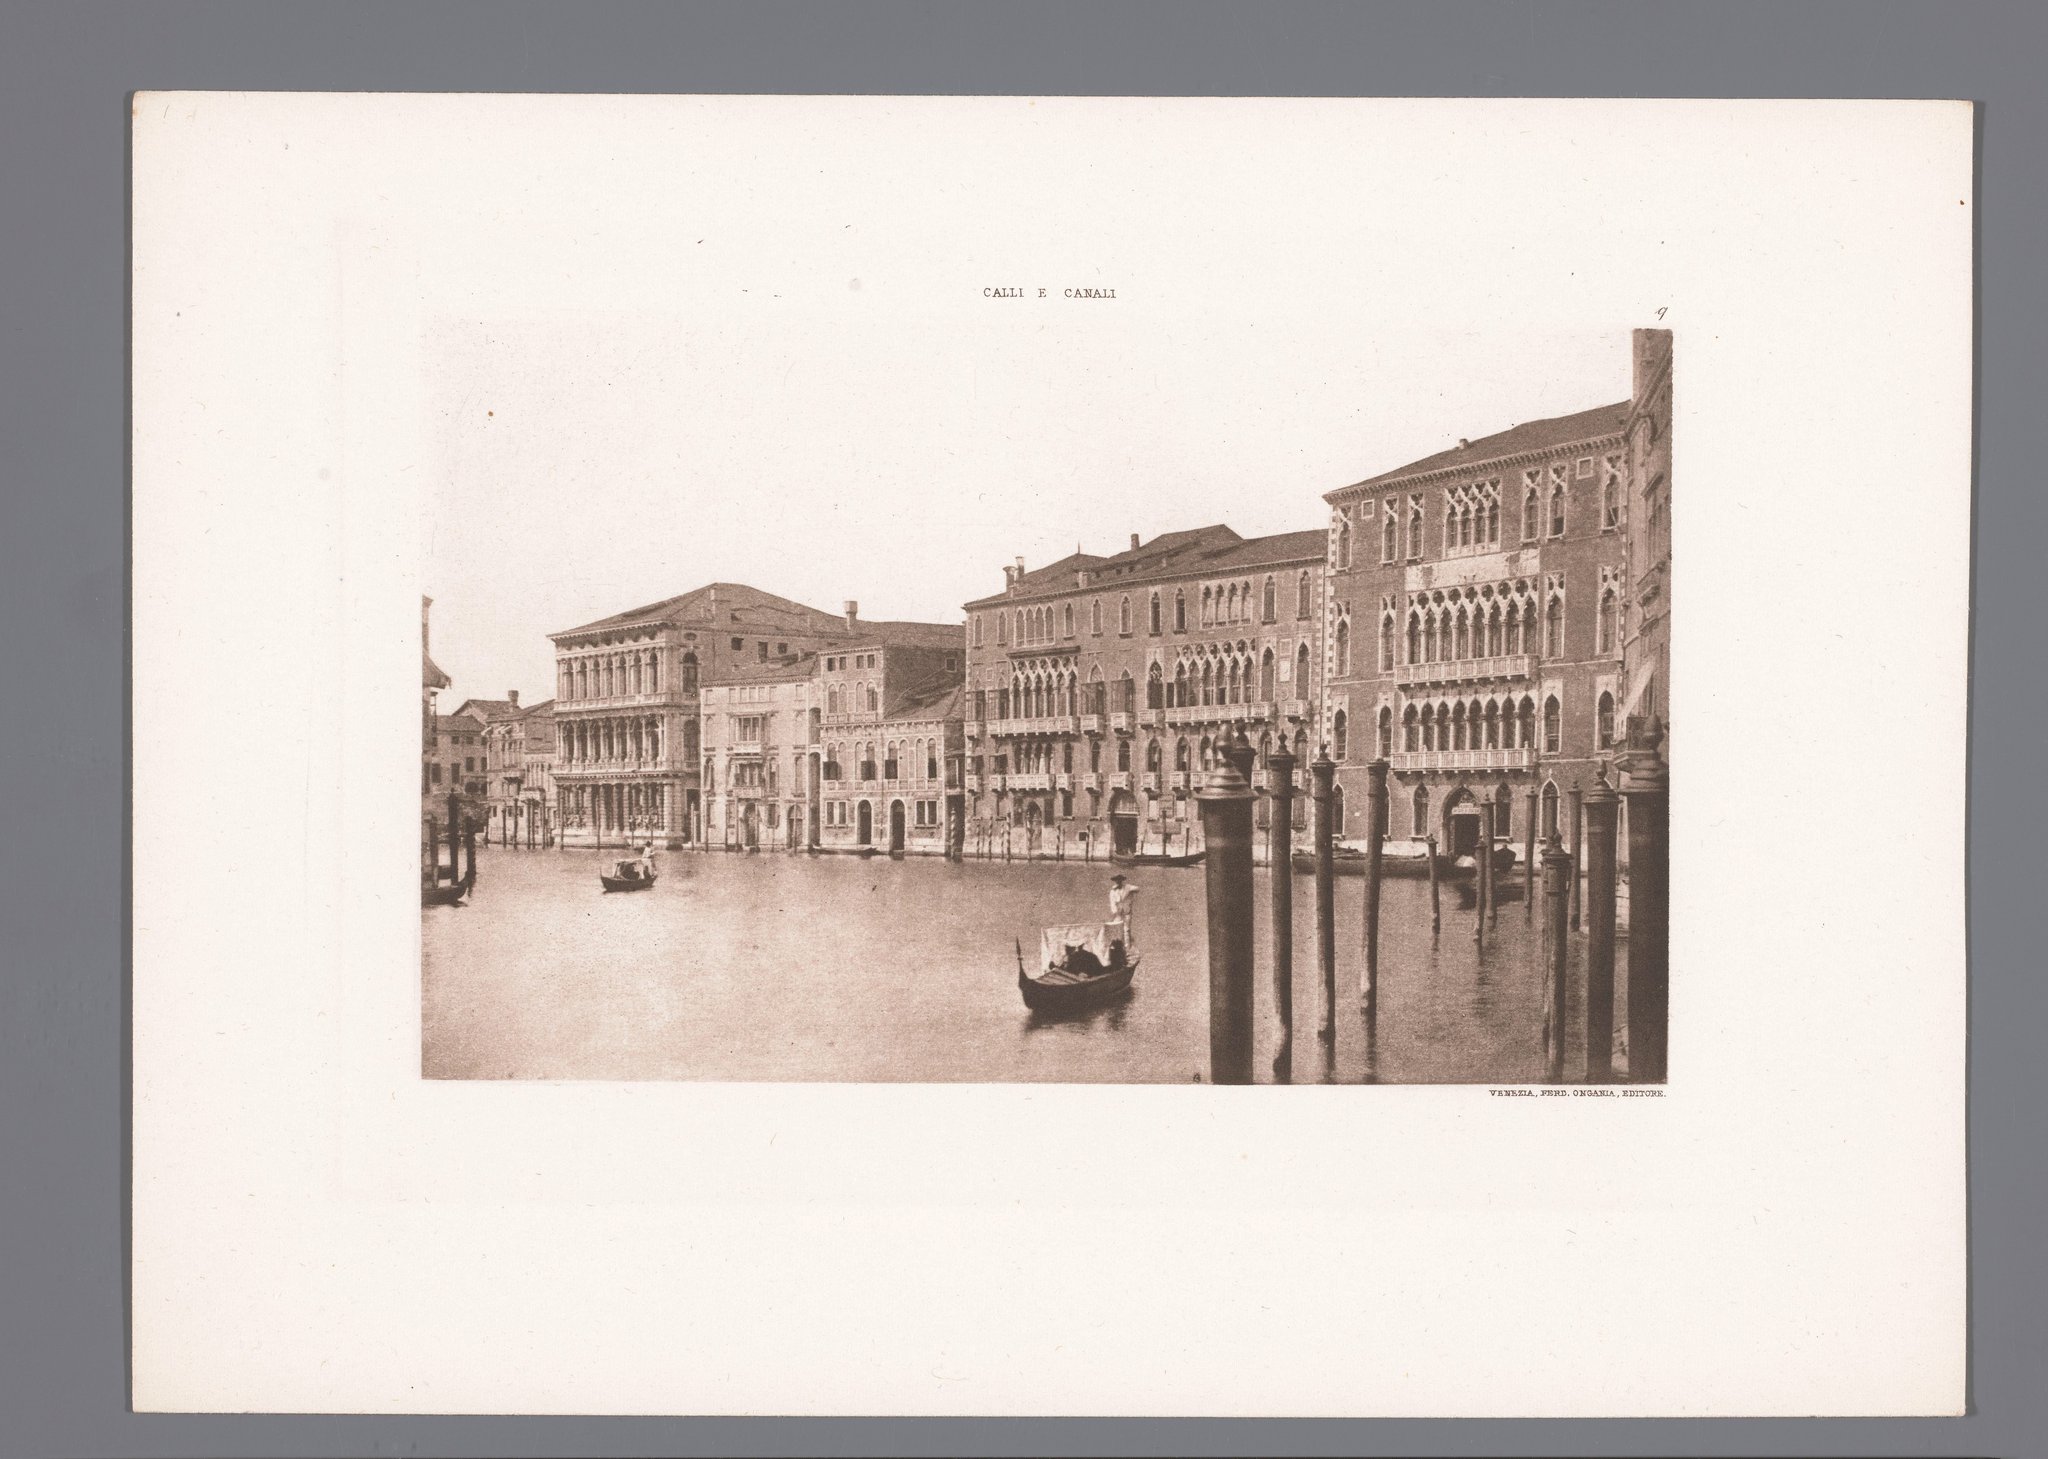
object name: page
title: Calli e canali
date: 1888-1898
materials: paper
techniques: photoaquatint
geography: venice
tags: canals, waters (in city), gondola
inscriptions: inscription: ‘q’